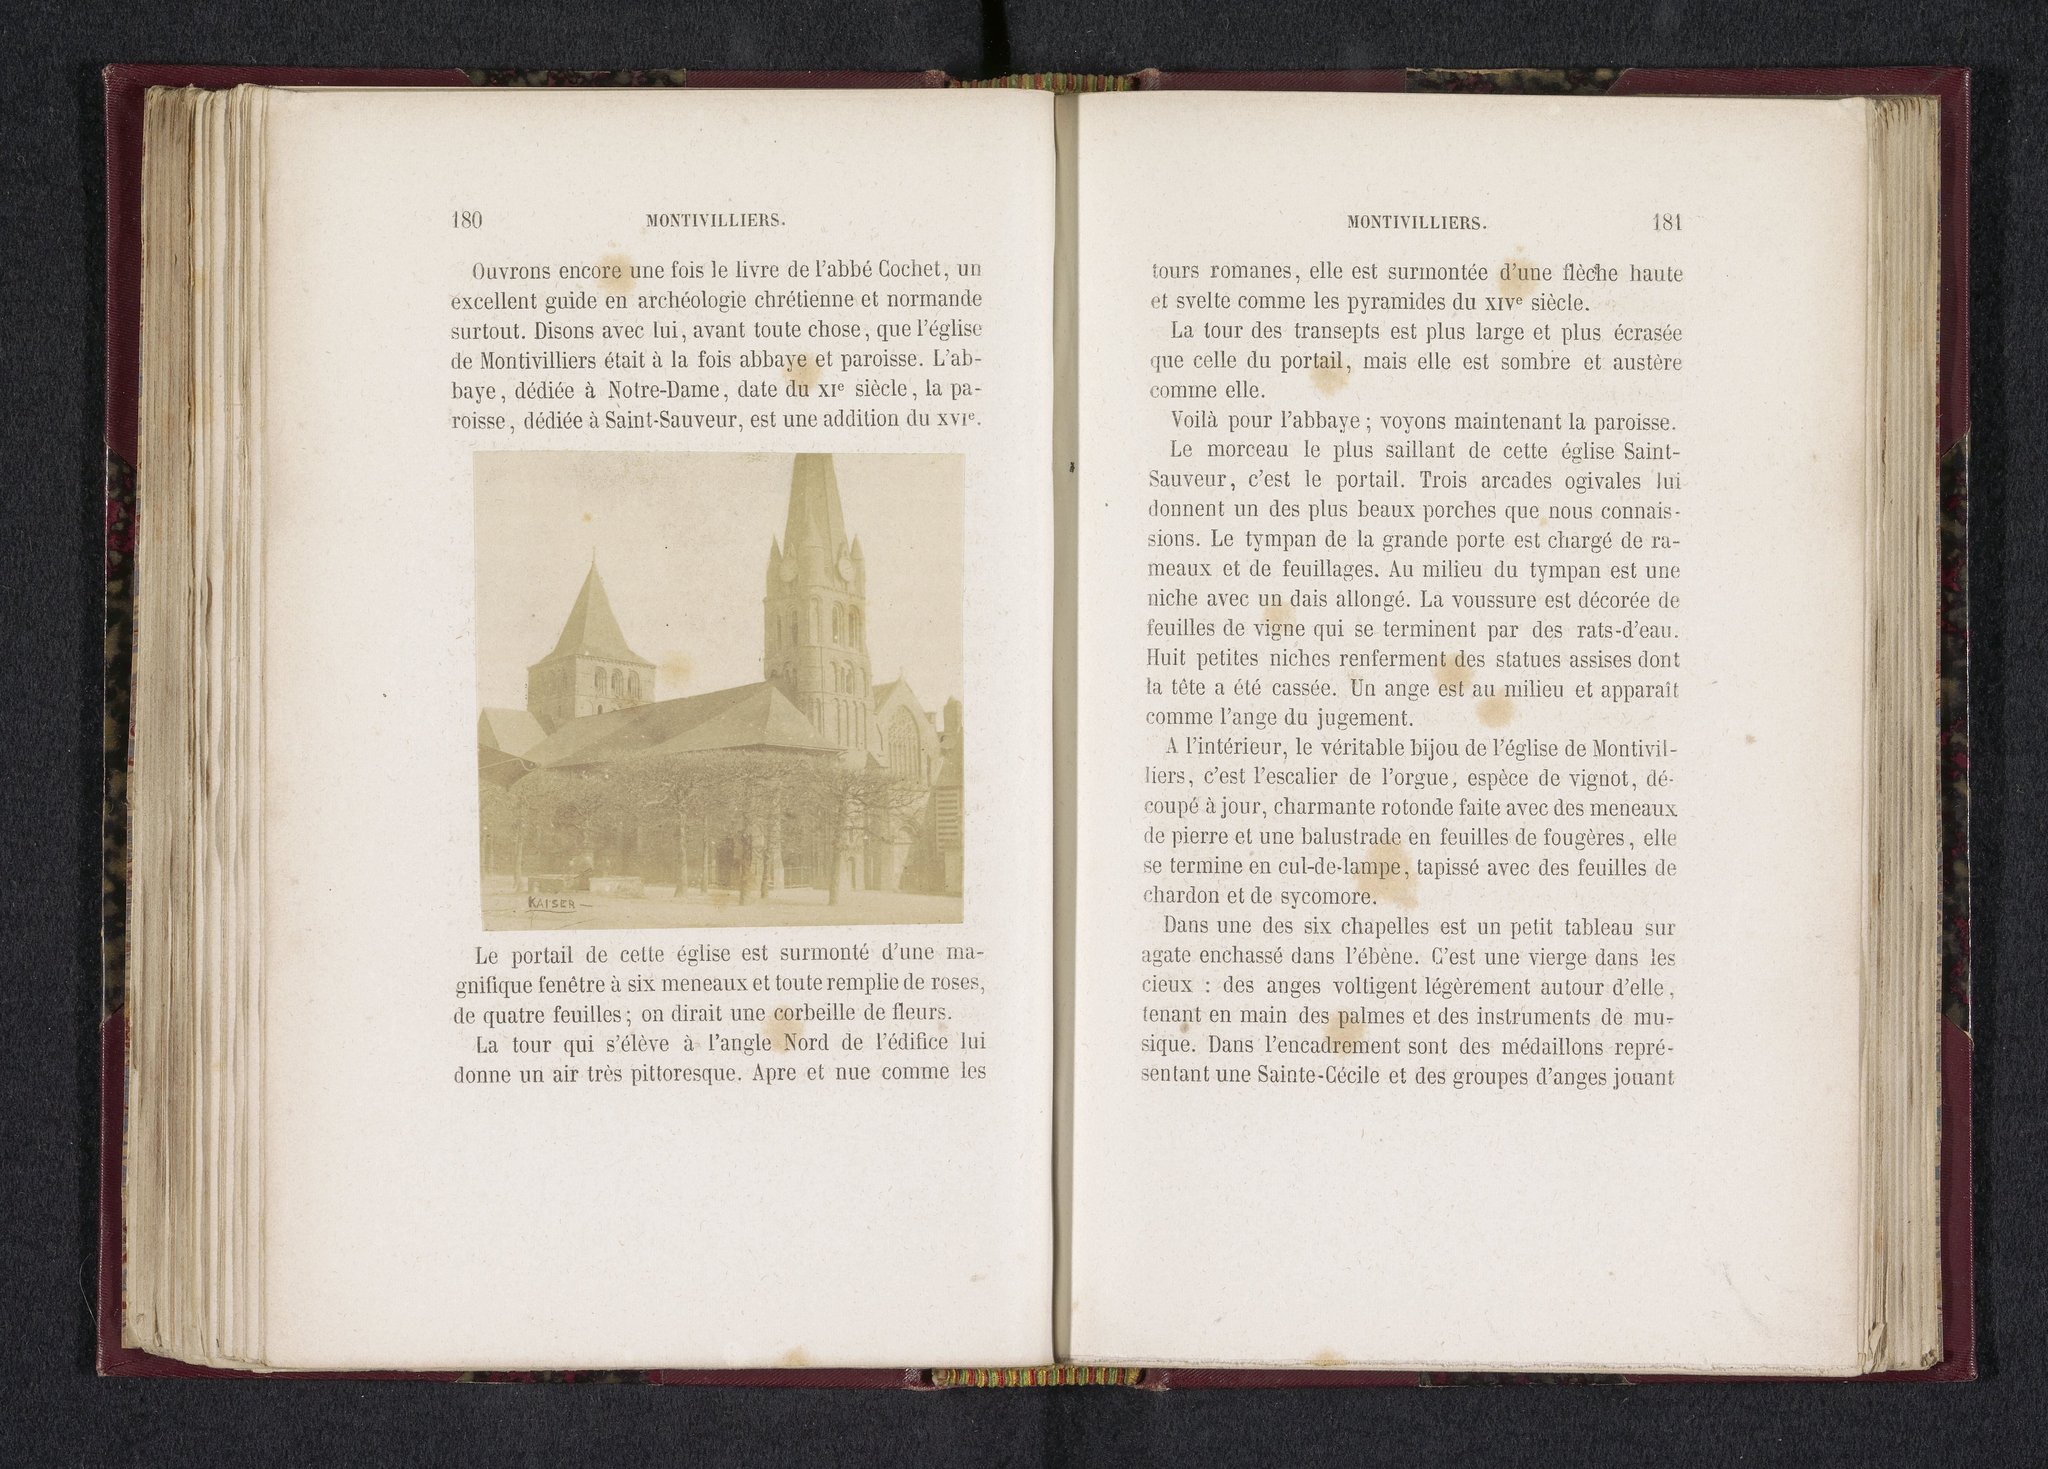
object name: page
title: Gezicht op de kerk van de abdij van Montivilliers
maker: kaiser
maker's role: fotograaf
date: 1850-1860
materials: photographic support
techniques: salted paper print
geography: montivilliers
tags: church (exterior)